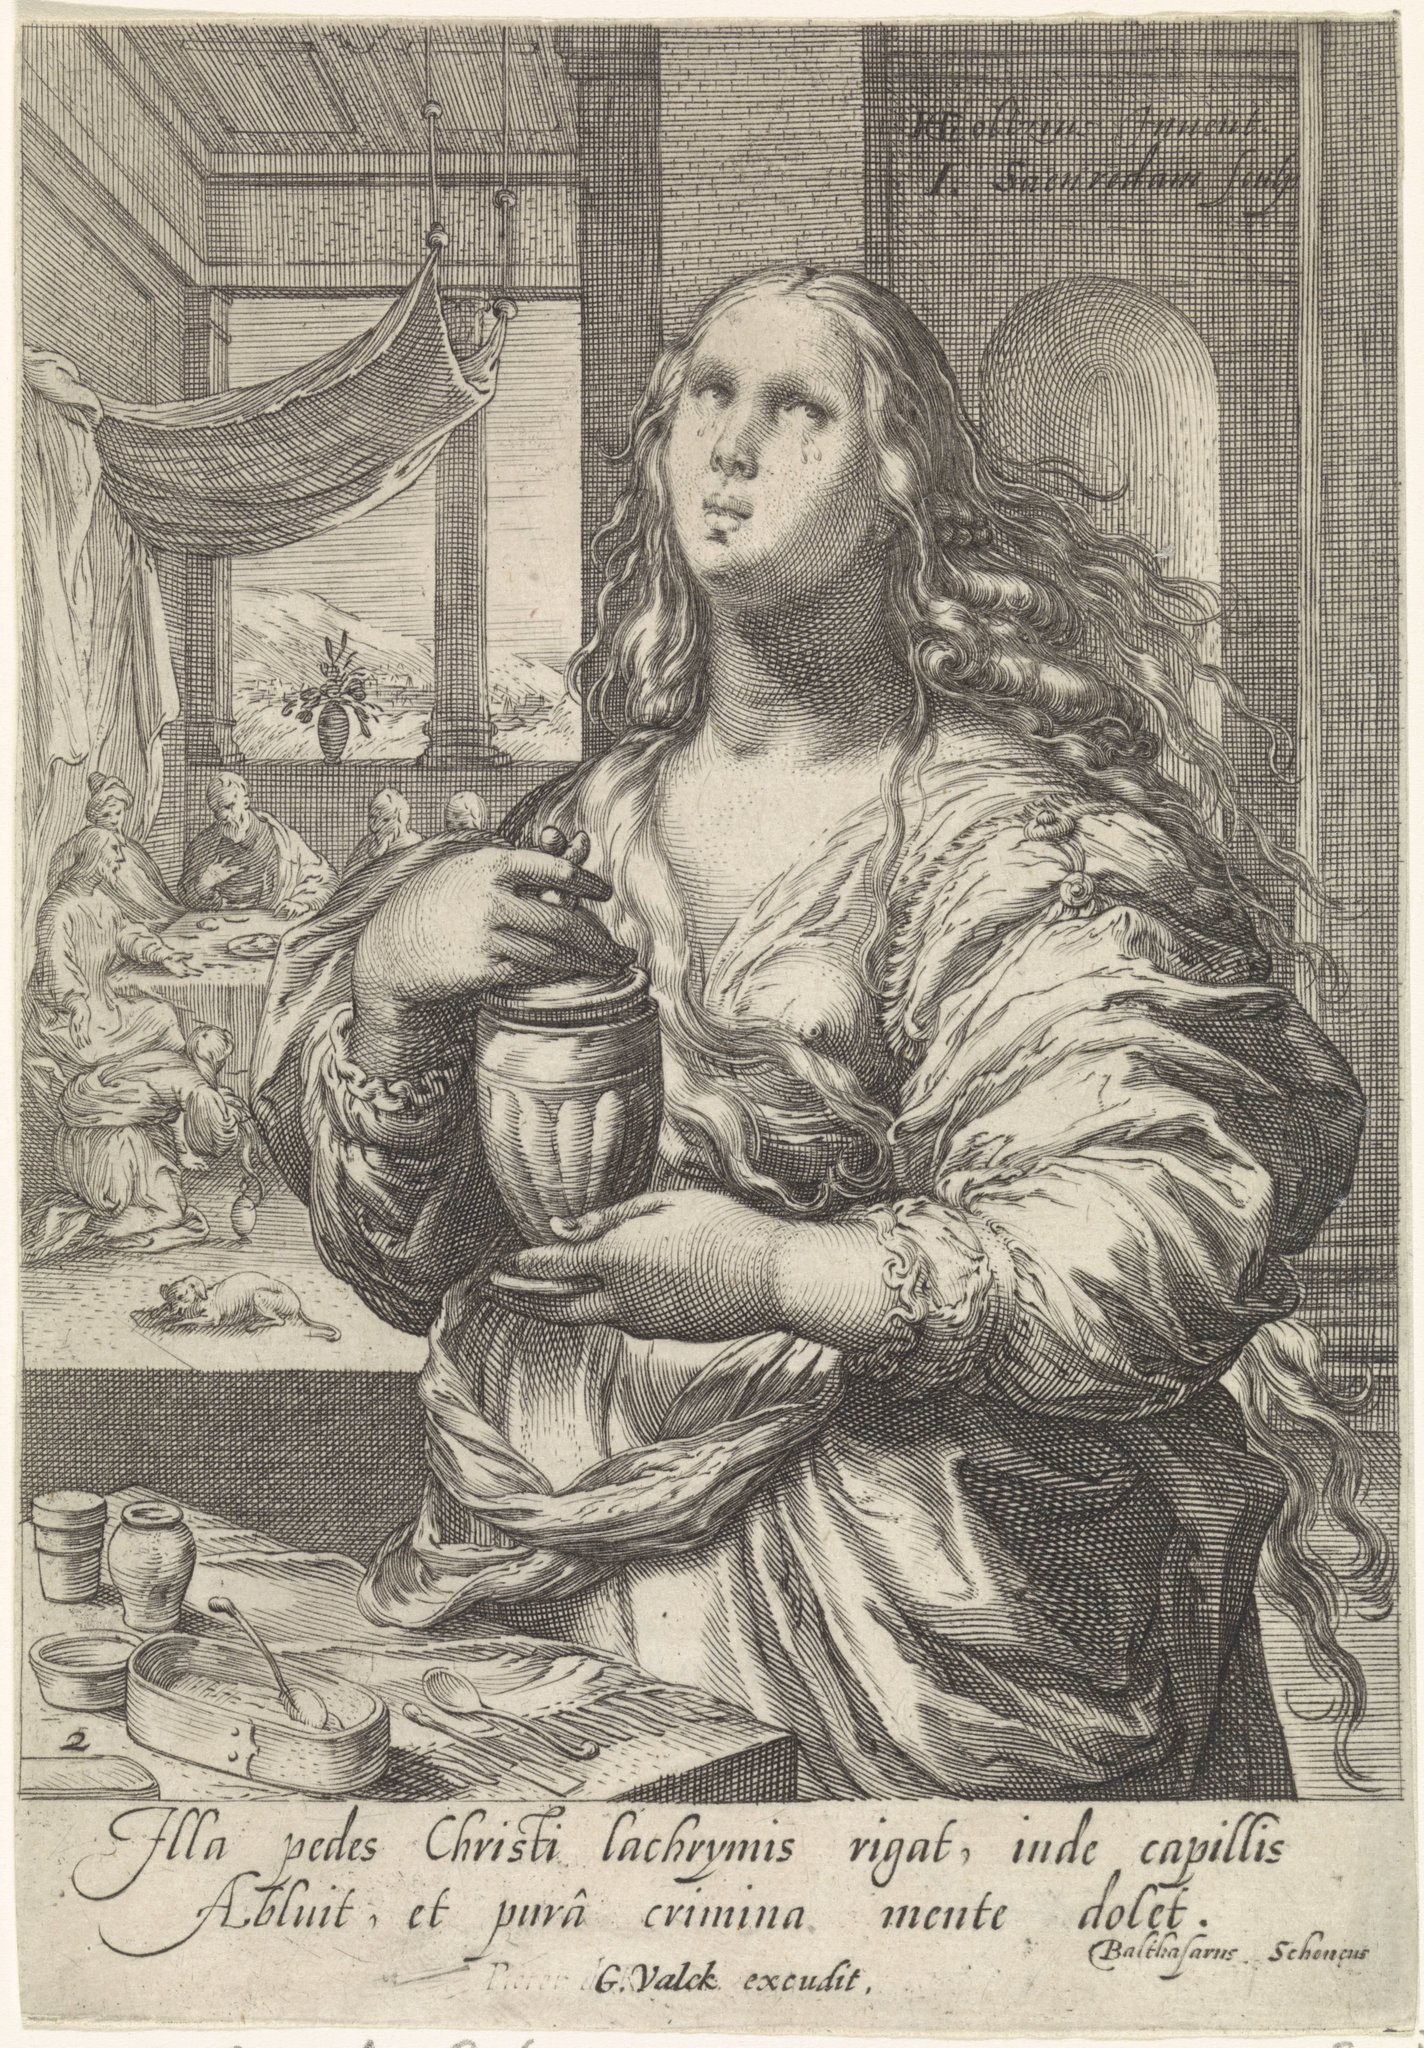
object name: print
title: Beroemde vrouwen uit het Nieuwe Testament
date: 1661-1726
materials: paper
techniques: engraving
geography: amsterdam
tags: christ's feet are anointed by mary (magdalene), the penitent harlot mary magdalene; possible attributes: book (or scroll), crown, crown of thorns, crucifix, jar of ointment, mirror, musical instrument, palm-branch, rosary, scourge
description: Maria Magdalena, huilend, met in haar hand een kruik met balsemolie. Op de achtergrond zalft zij de voeten van Christus wanneer hij te gast is bij Simon de Farizeeër. De prent heeft een Latijns onderschrift en maakt deel uit van een prentserie met beroemde vrouwen uit het Nieuwe Testament